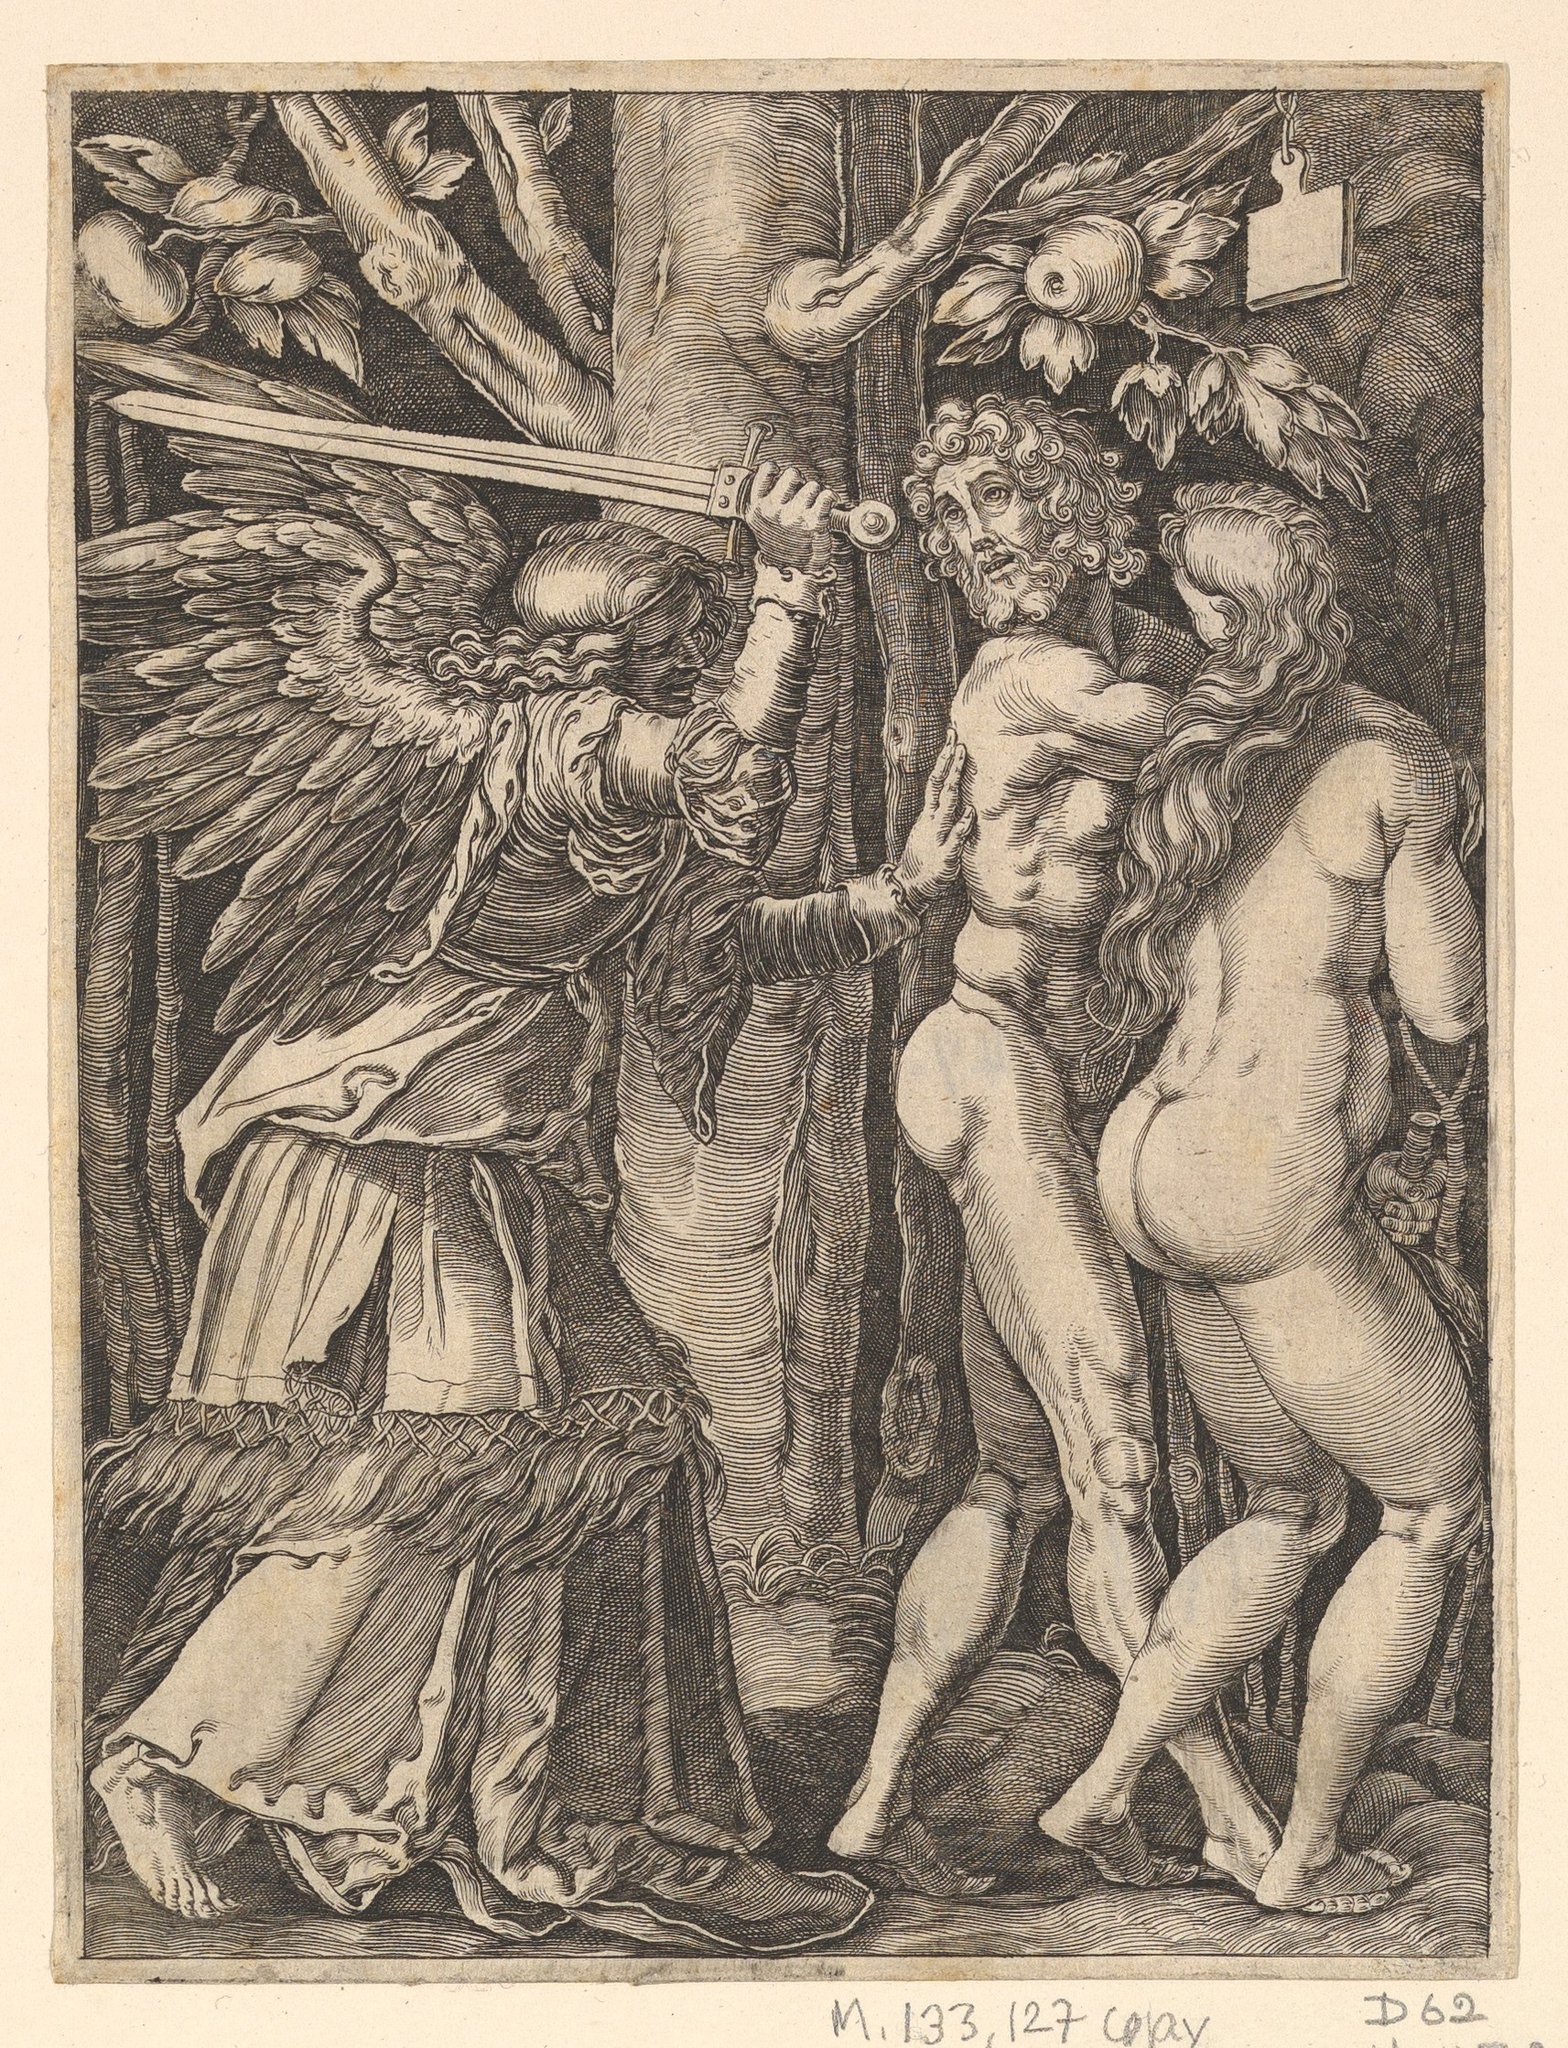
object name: print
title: Engraved copies of The Little Passion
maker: albrecht dürer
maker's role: artist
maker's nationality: german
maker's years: 1471-1528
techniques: engraving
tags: swords,male nudes,female nudes